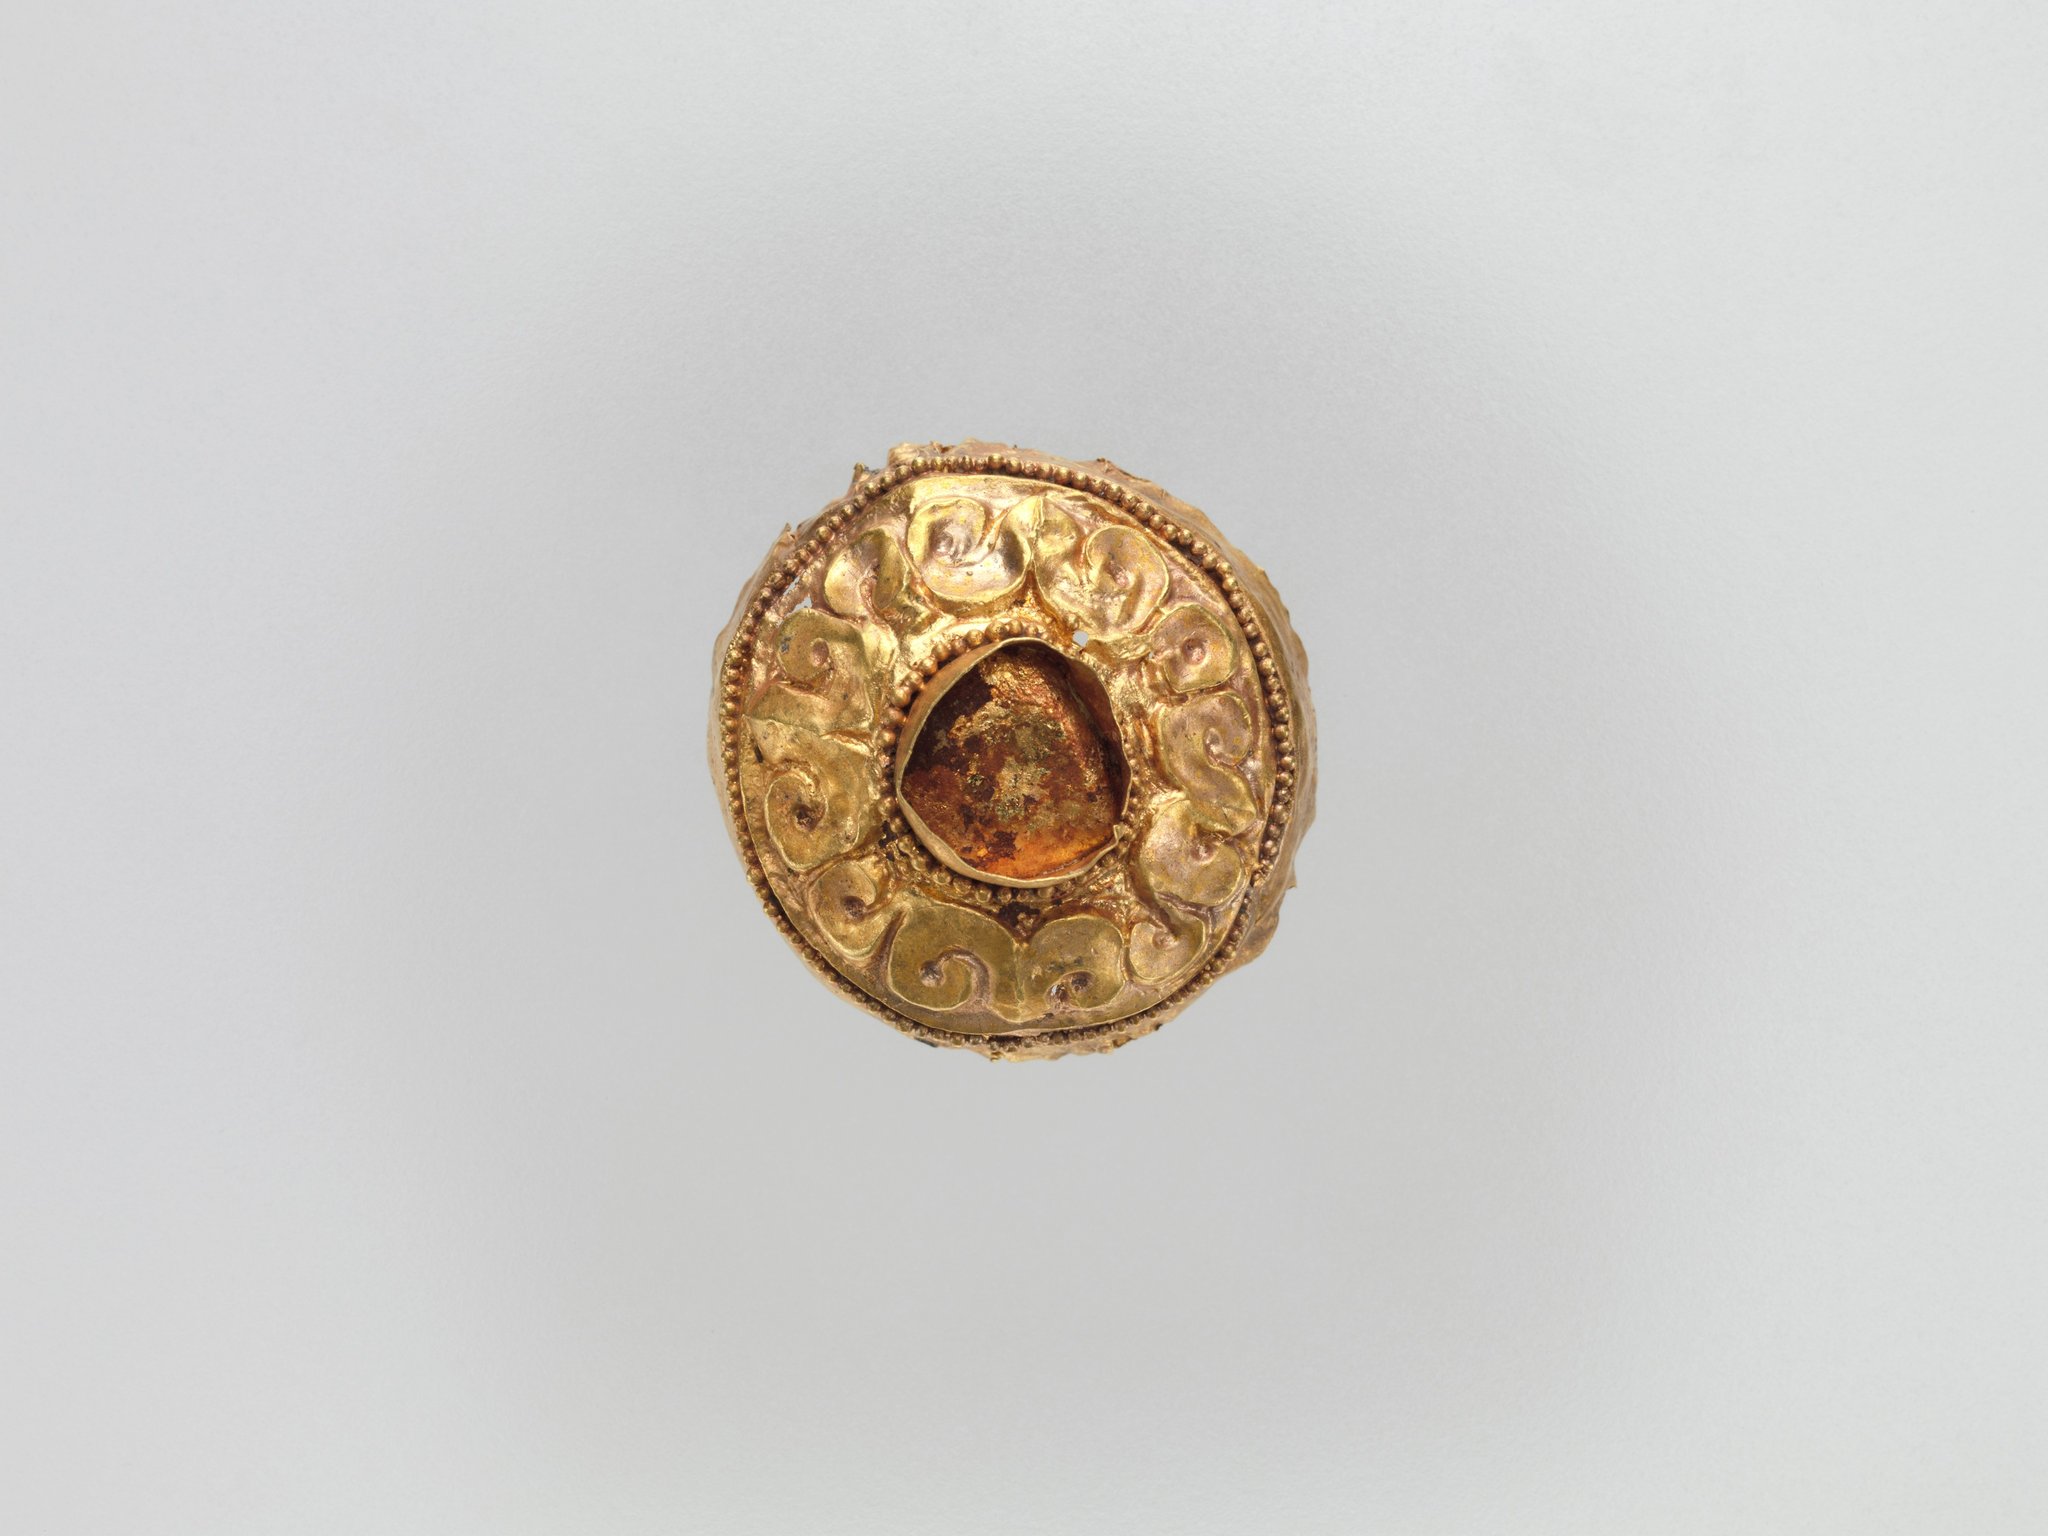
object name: plaque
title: Cap-Shaped Plaque with Lion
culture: chinese or central asian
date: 601-900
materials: gold